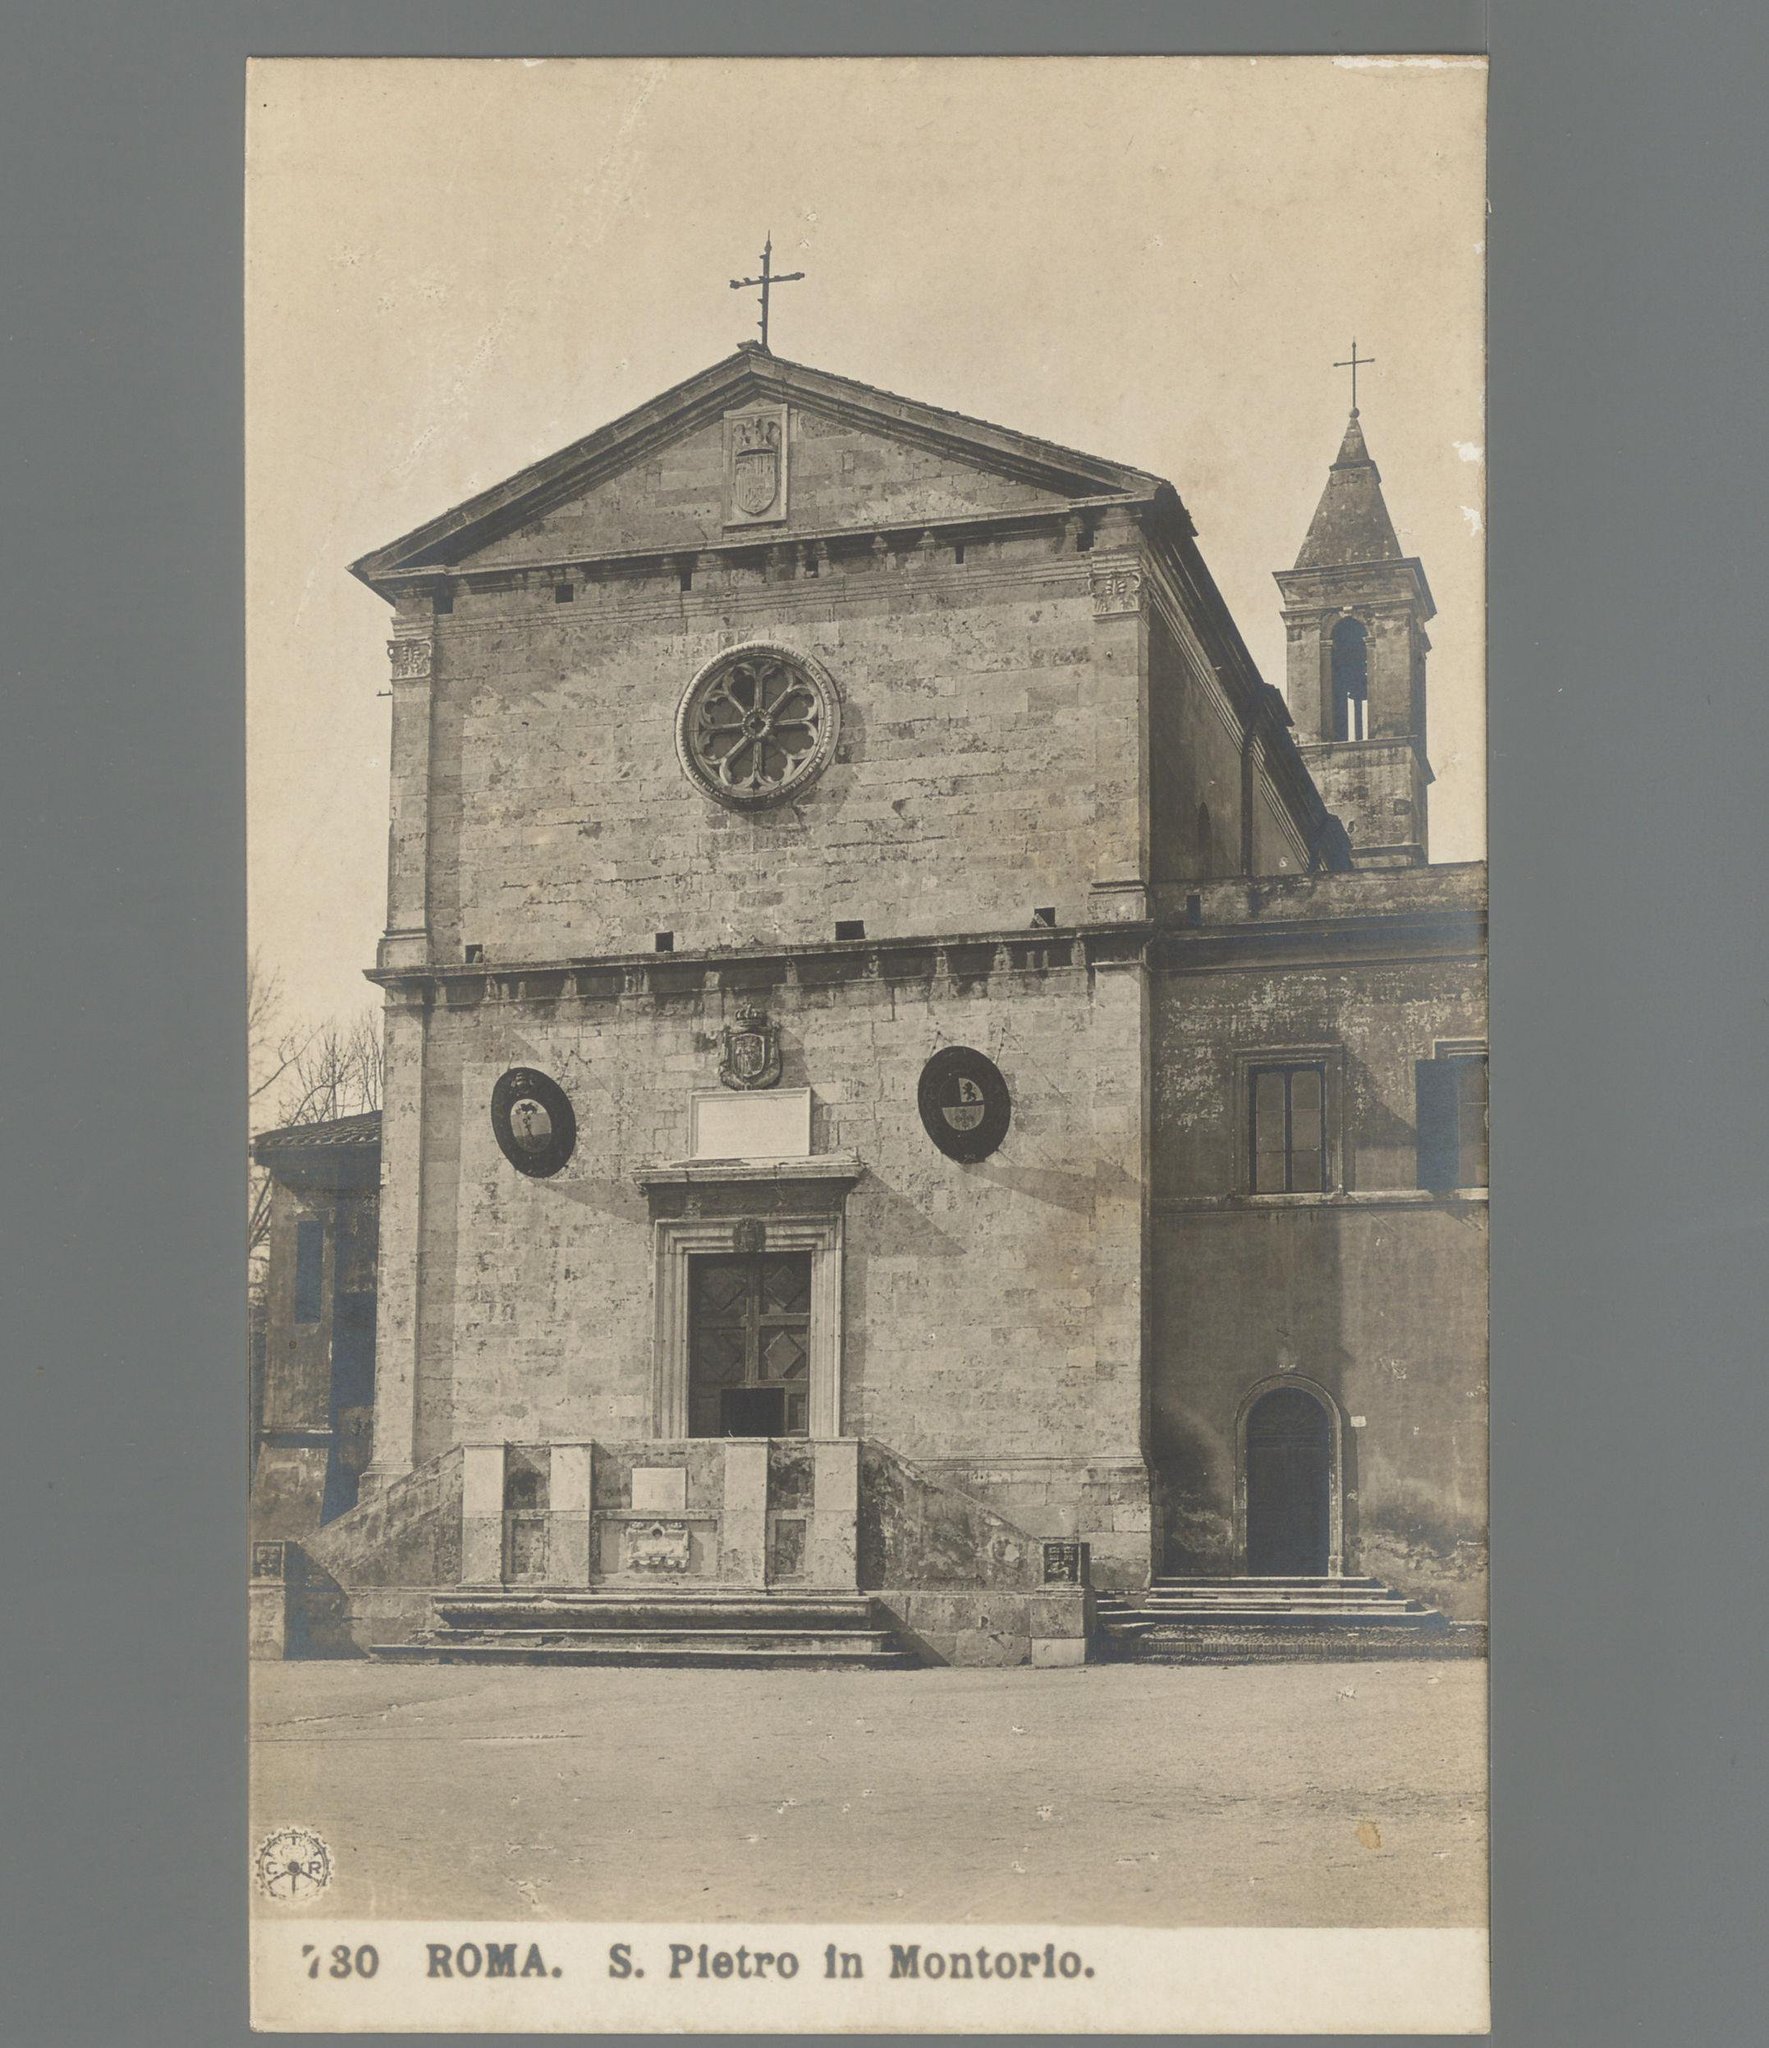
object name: photograph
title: Roma. S. Pietro in Montorio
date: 1906-1930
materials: photographic support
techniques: photography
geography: milan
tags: church (exterior)